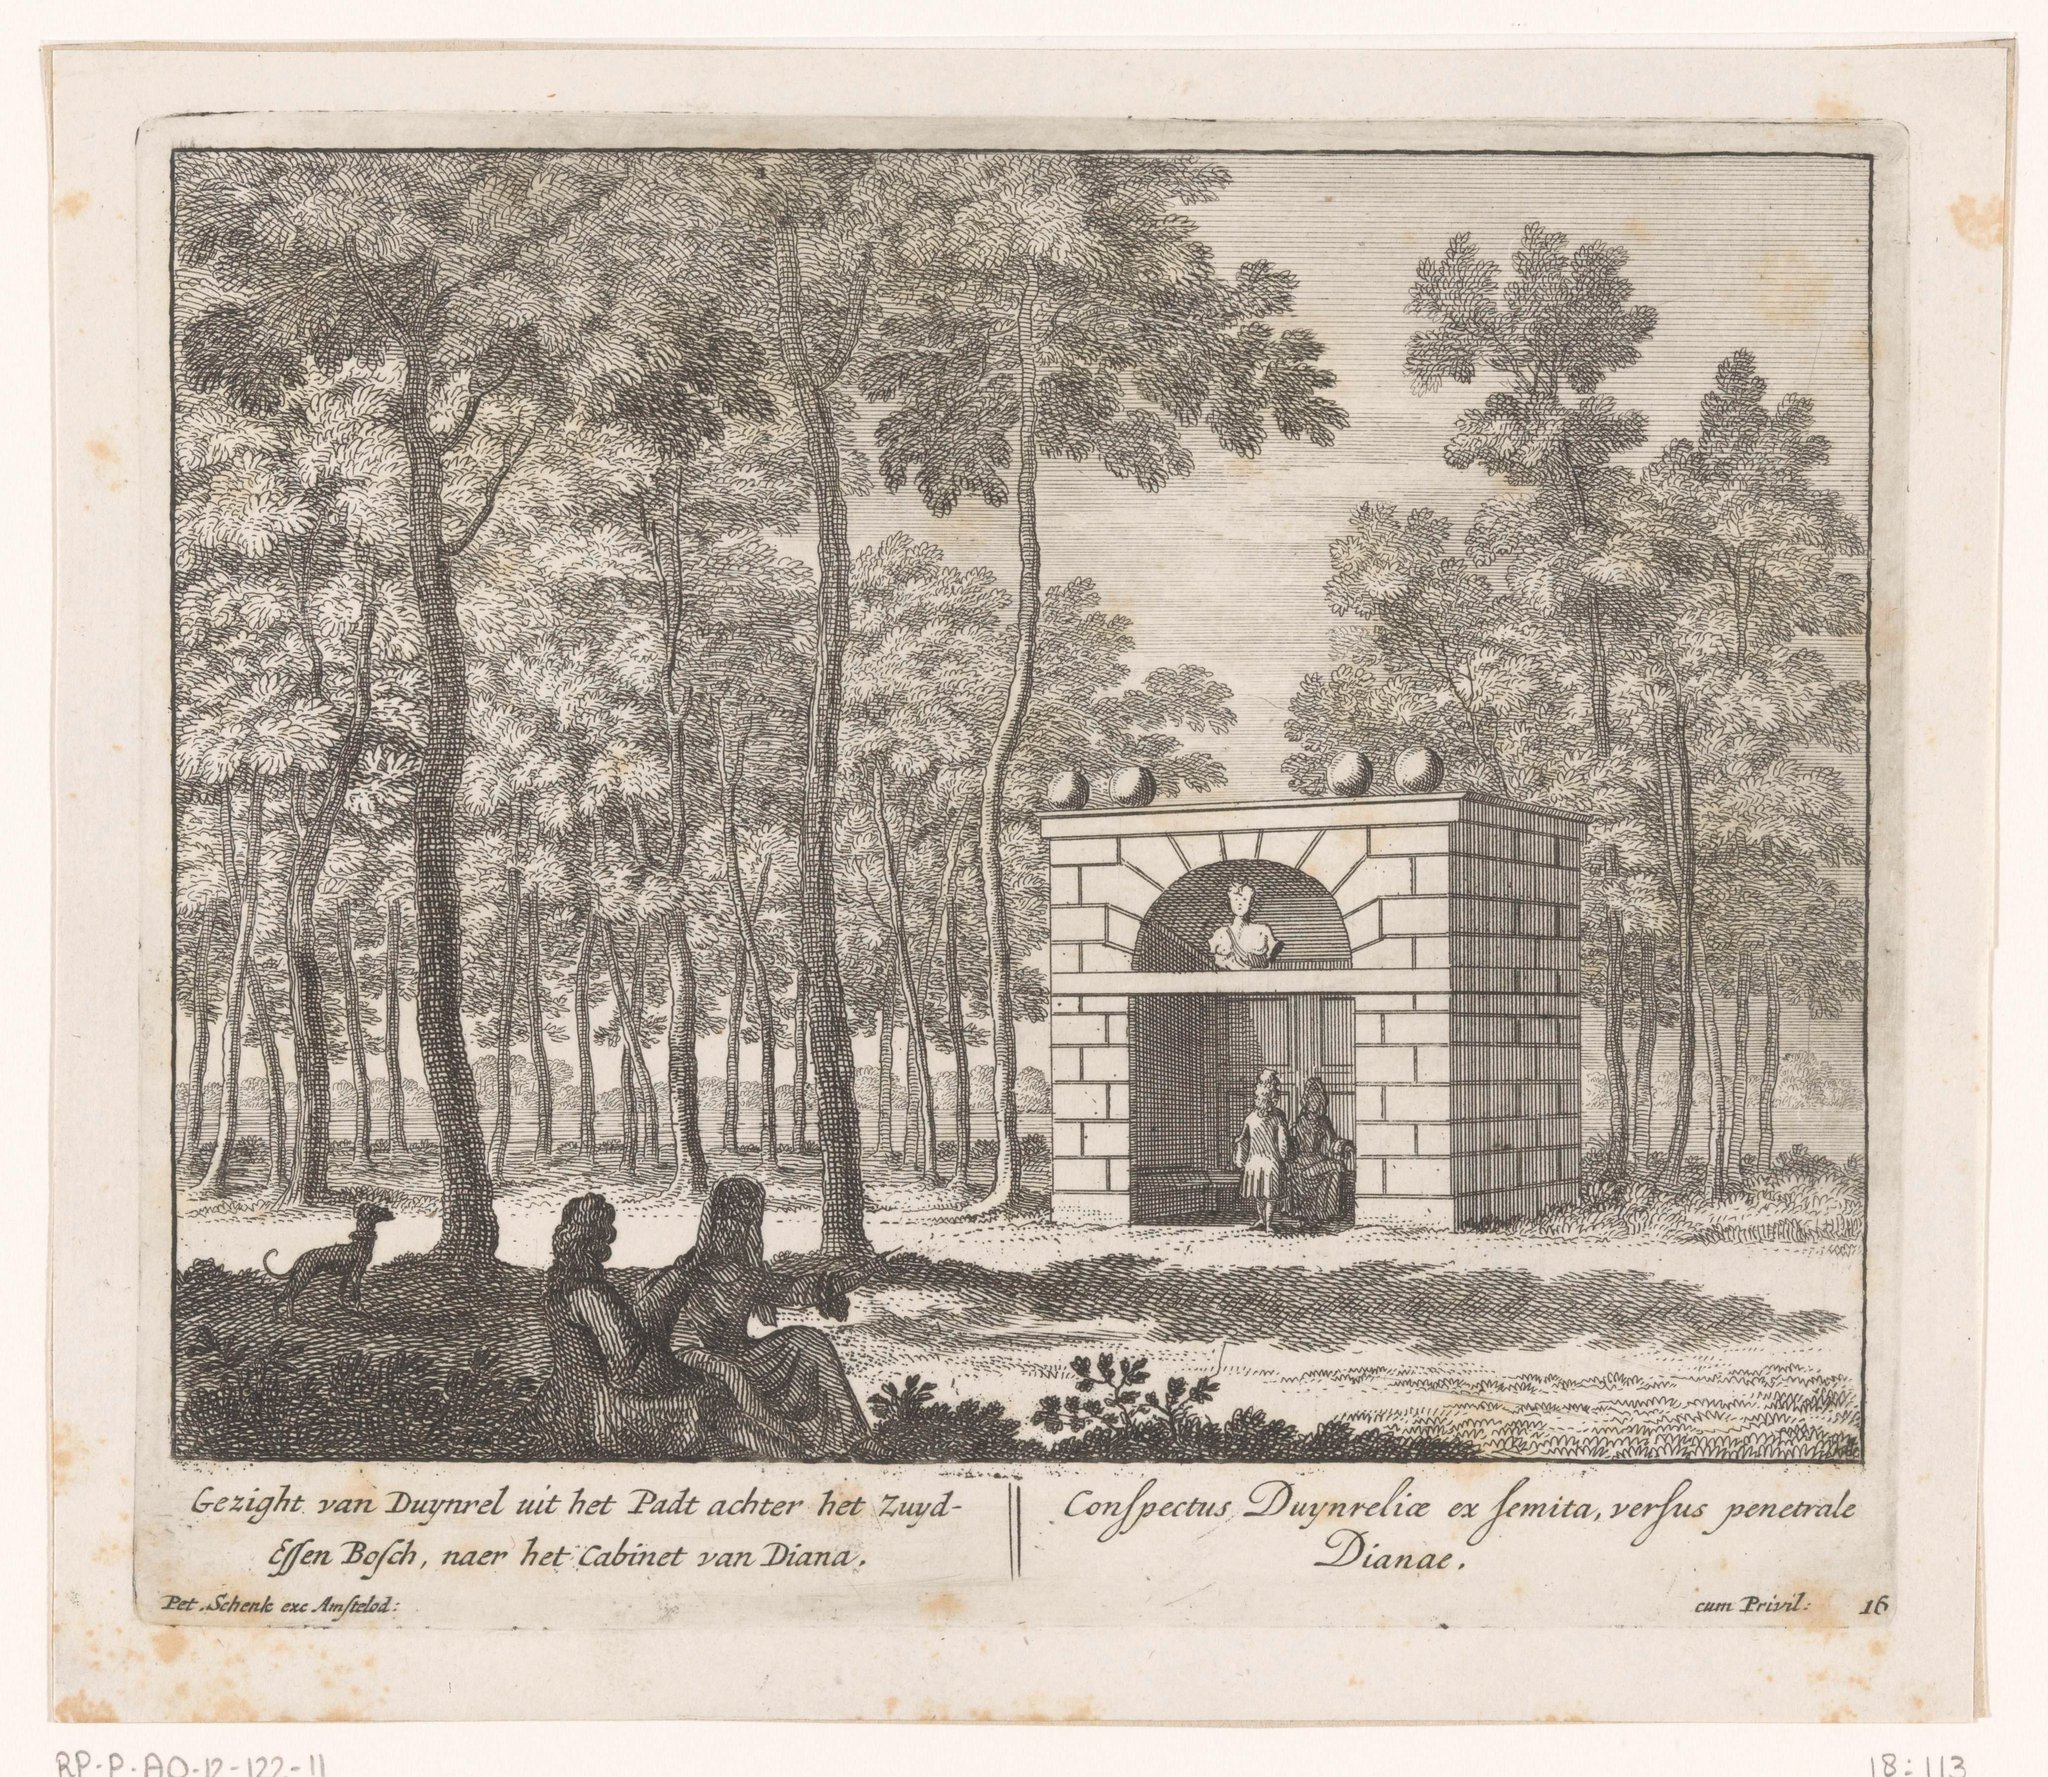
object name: print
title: Gezight van Duynrel uit het padt achter het zuyd-essen bosch, naer het cabinet van Diana / Conspectus Duynreliae ex femita, versus pentrale Dianae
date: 1675-1711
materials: paper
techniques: engraving, etching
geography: amsterdam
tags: (story of) diana (artemis), forest, wood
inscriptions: collector's mark: Lugt 2228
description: Gezicht op het kabinet van Diana, met een buste van Diana, achter het essenbos van buitenplaats Duinrell. In het kabinet twee figuren. Op de voorgrond twee zittende figuren en een hond. Rechtsonder genummerd: 16. Prent uit een serie van zestien prenten van Duinrell.